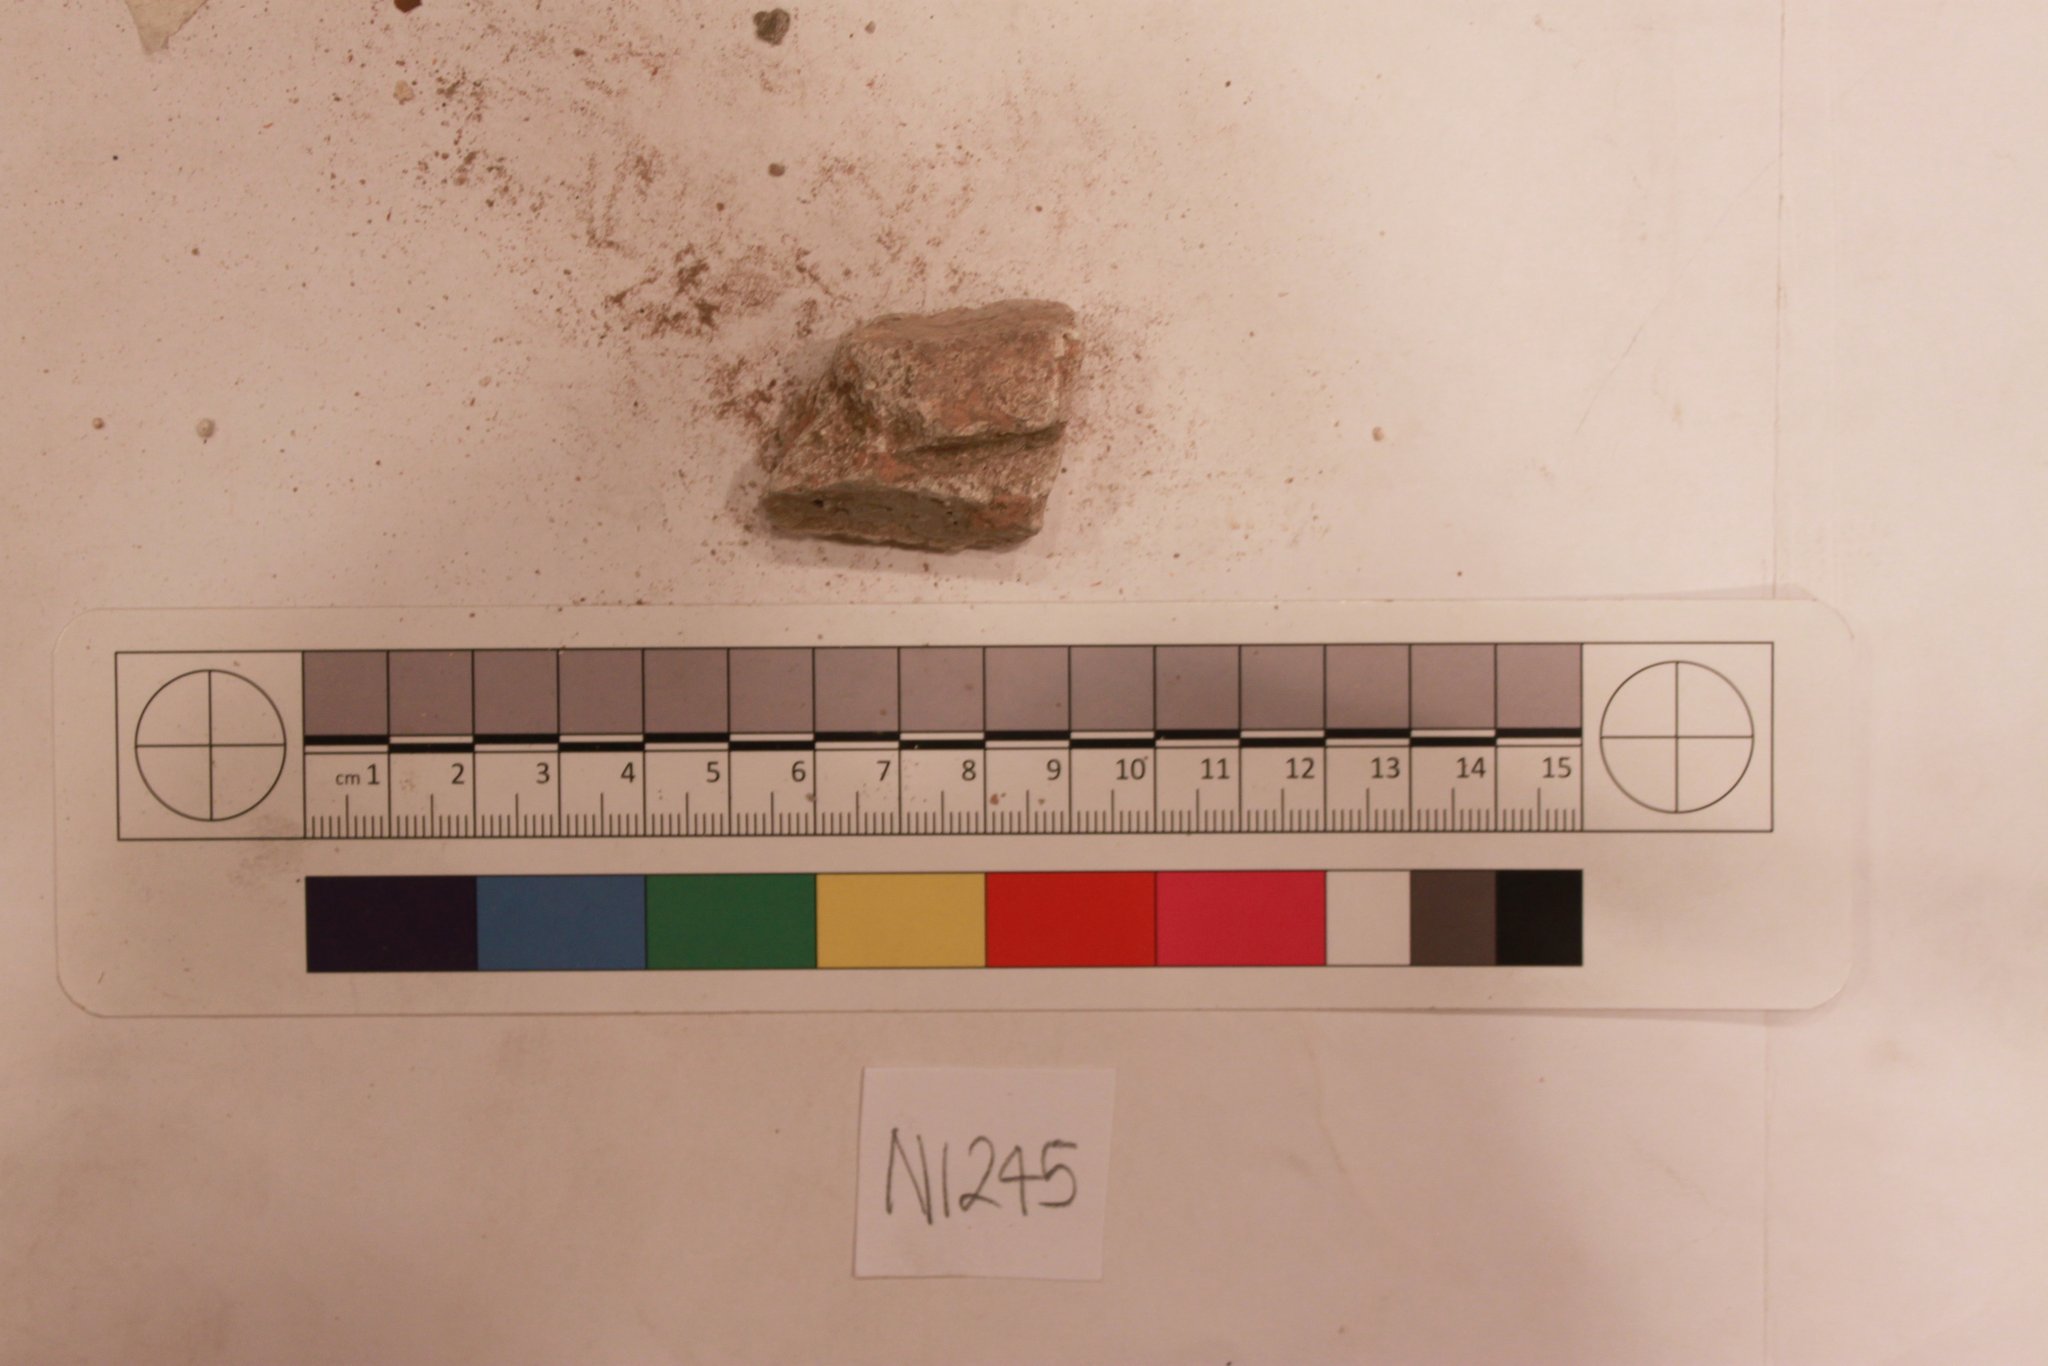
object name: fragment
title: Stucco Fragment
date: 701-1200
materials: plaster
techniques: carving, painting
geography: iran